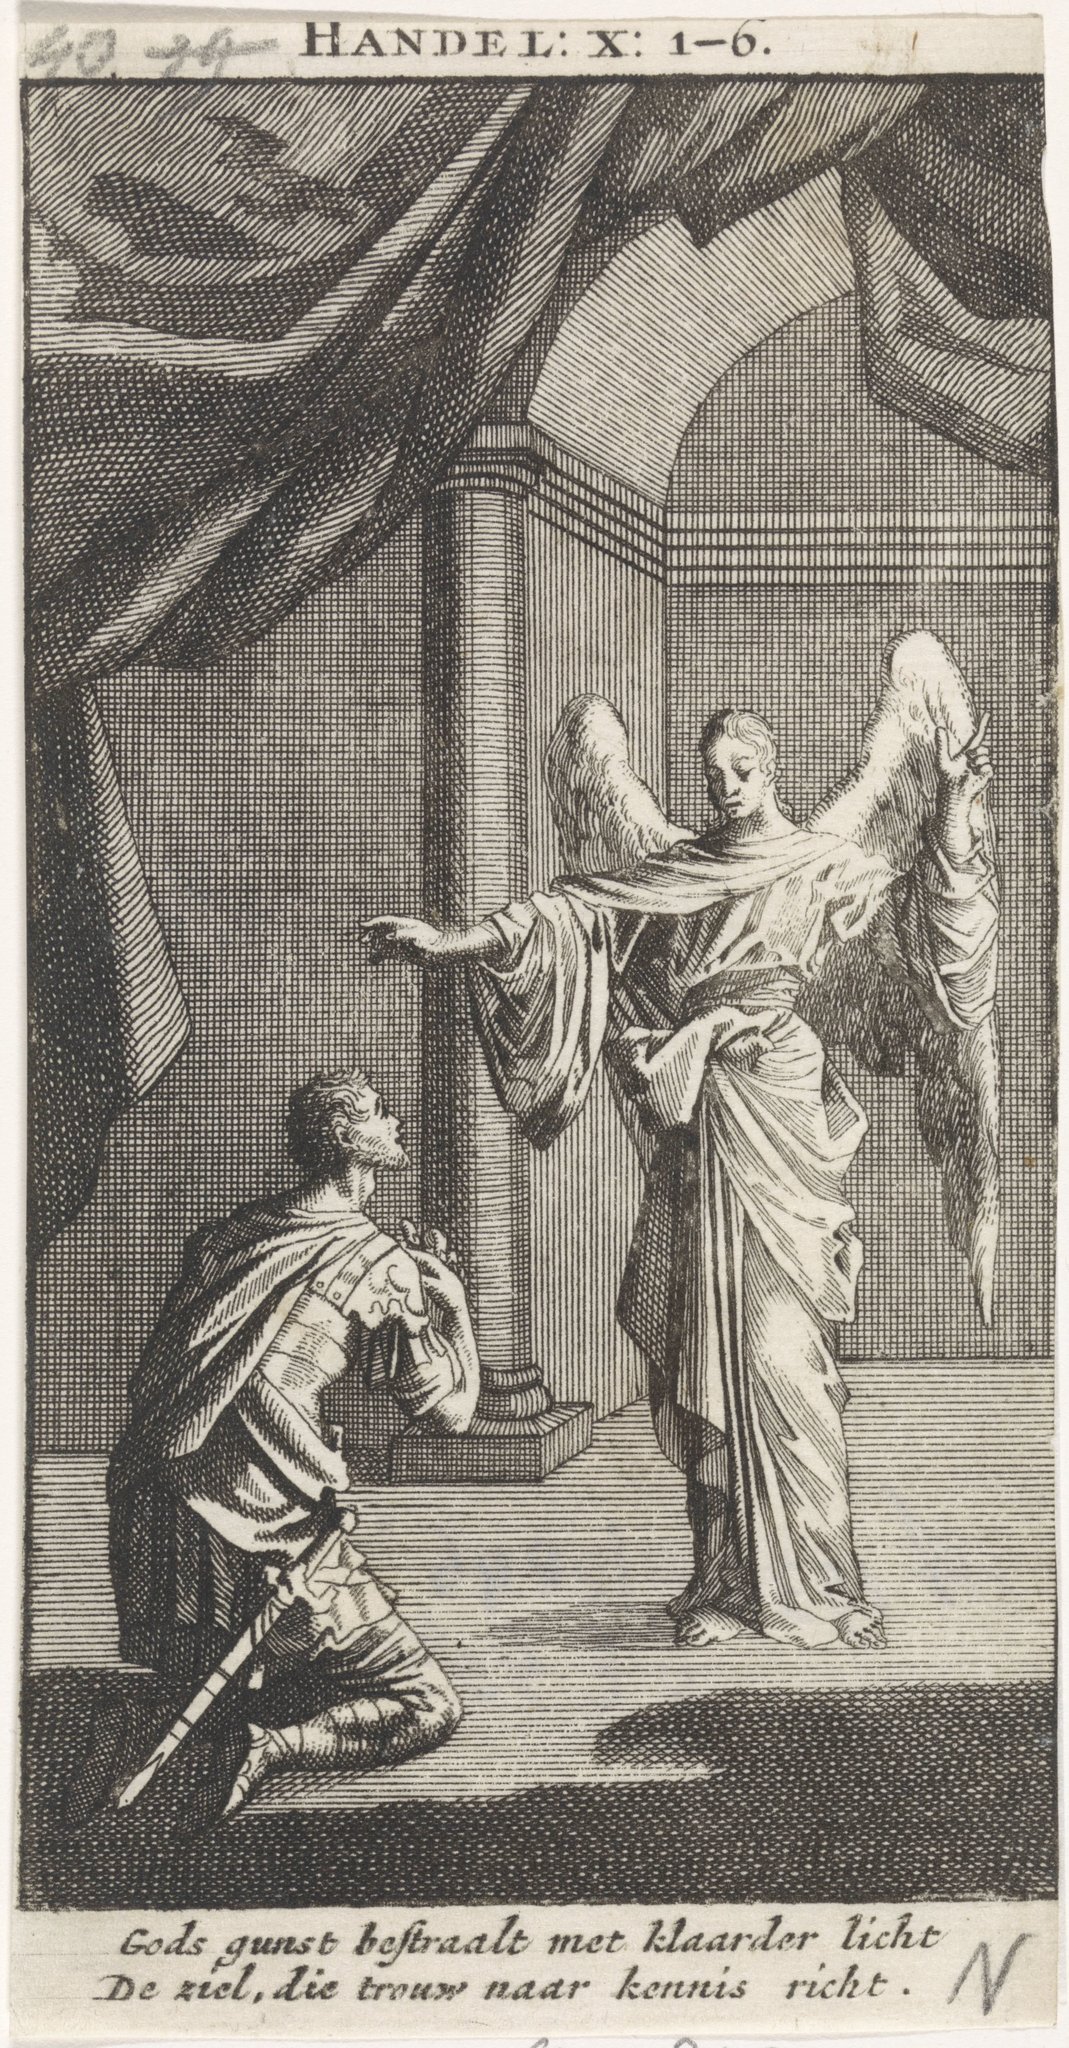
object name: print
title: Cornelius knielt voor de tot hem gezonden engel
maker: Anonymous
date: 1712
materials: paper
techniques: etching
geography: amsterdam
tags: cornelius the centurion and the angel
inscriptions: collector's mark: Lugt 2228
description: Kopie van illustratie voor: Luyken, Jan. Bybel printen. Amsterdam: Pieter Arentsz. II (wed.) en Cornelis van der Sys, 1712, p. 39.